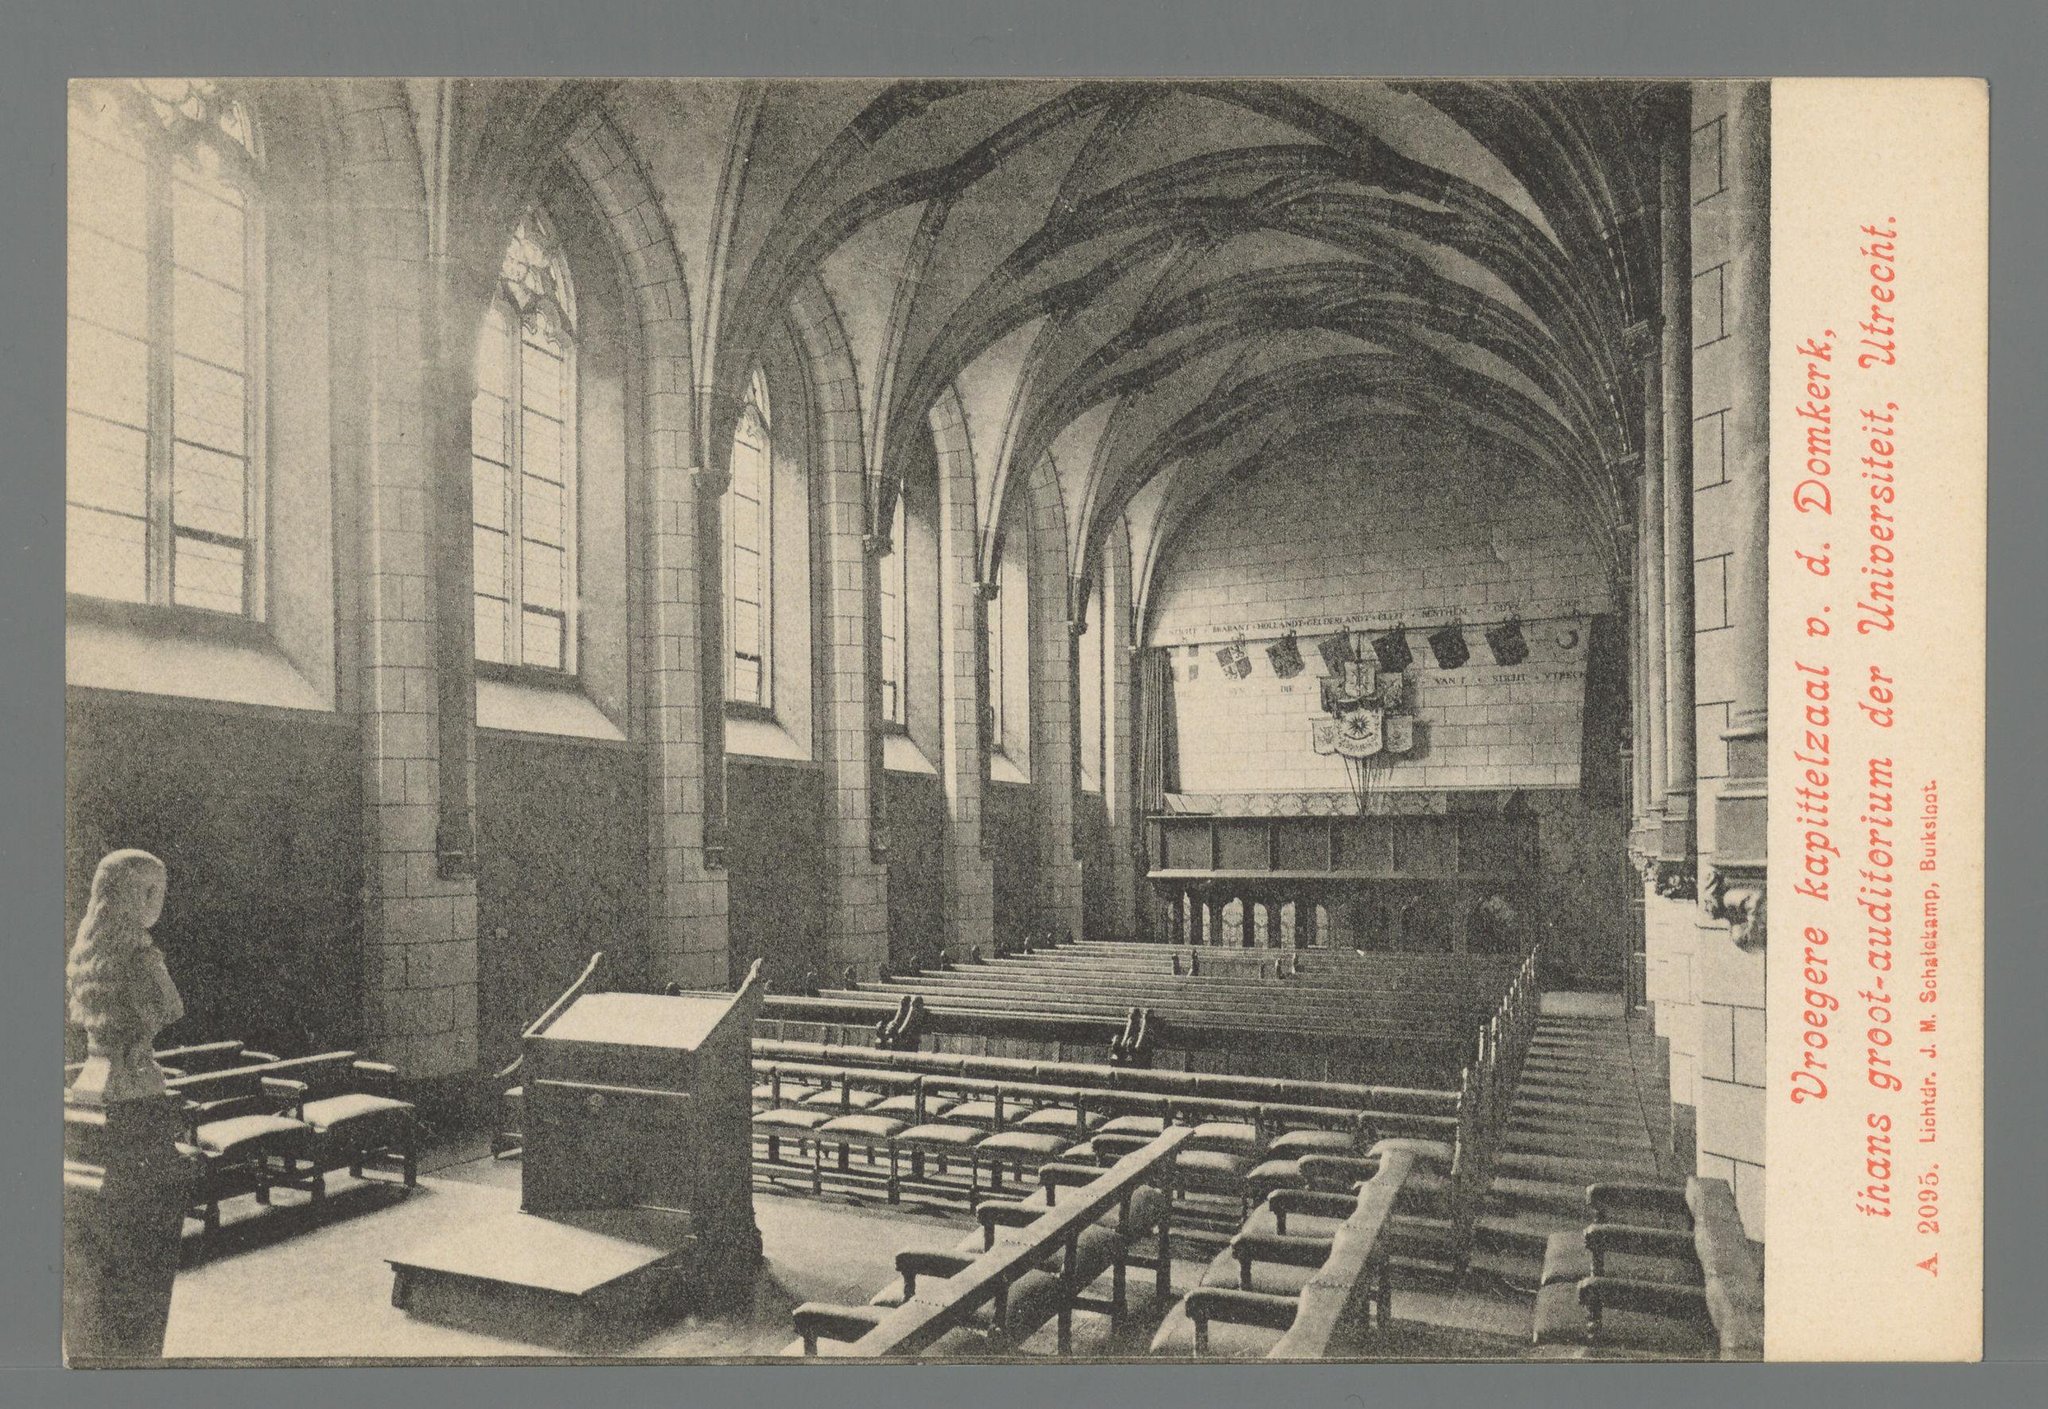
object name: ansichtkaart, prentbriefkaart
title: Vroegere kapittelzaal v. d. Domkerk, thans groot-auditorium der Universiteit, Utrecht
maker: johan marinus schalekamp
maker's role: publisher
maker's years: 1844-1912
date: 1897-1910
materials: cardboard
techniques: photograph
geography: buiksloot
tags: auditorium ~ theatre, etc., church (exterior)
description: Vermoedelijk is deze prentbriefkaart oorspronkelijk gedrukt in de periode 1897-1905 en zijn op verso later een deelstreep en lijnen voor het adres bijgedrukt, zodat de kaart na 1905 alsnog geldig was en verkocht kon worden.